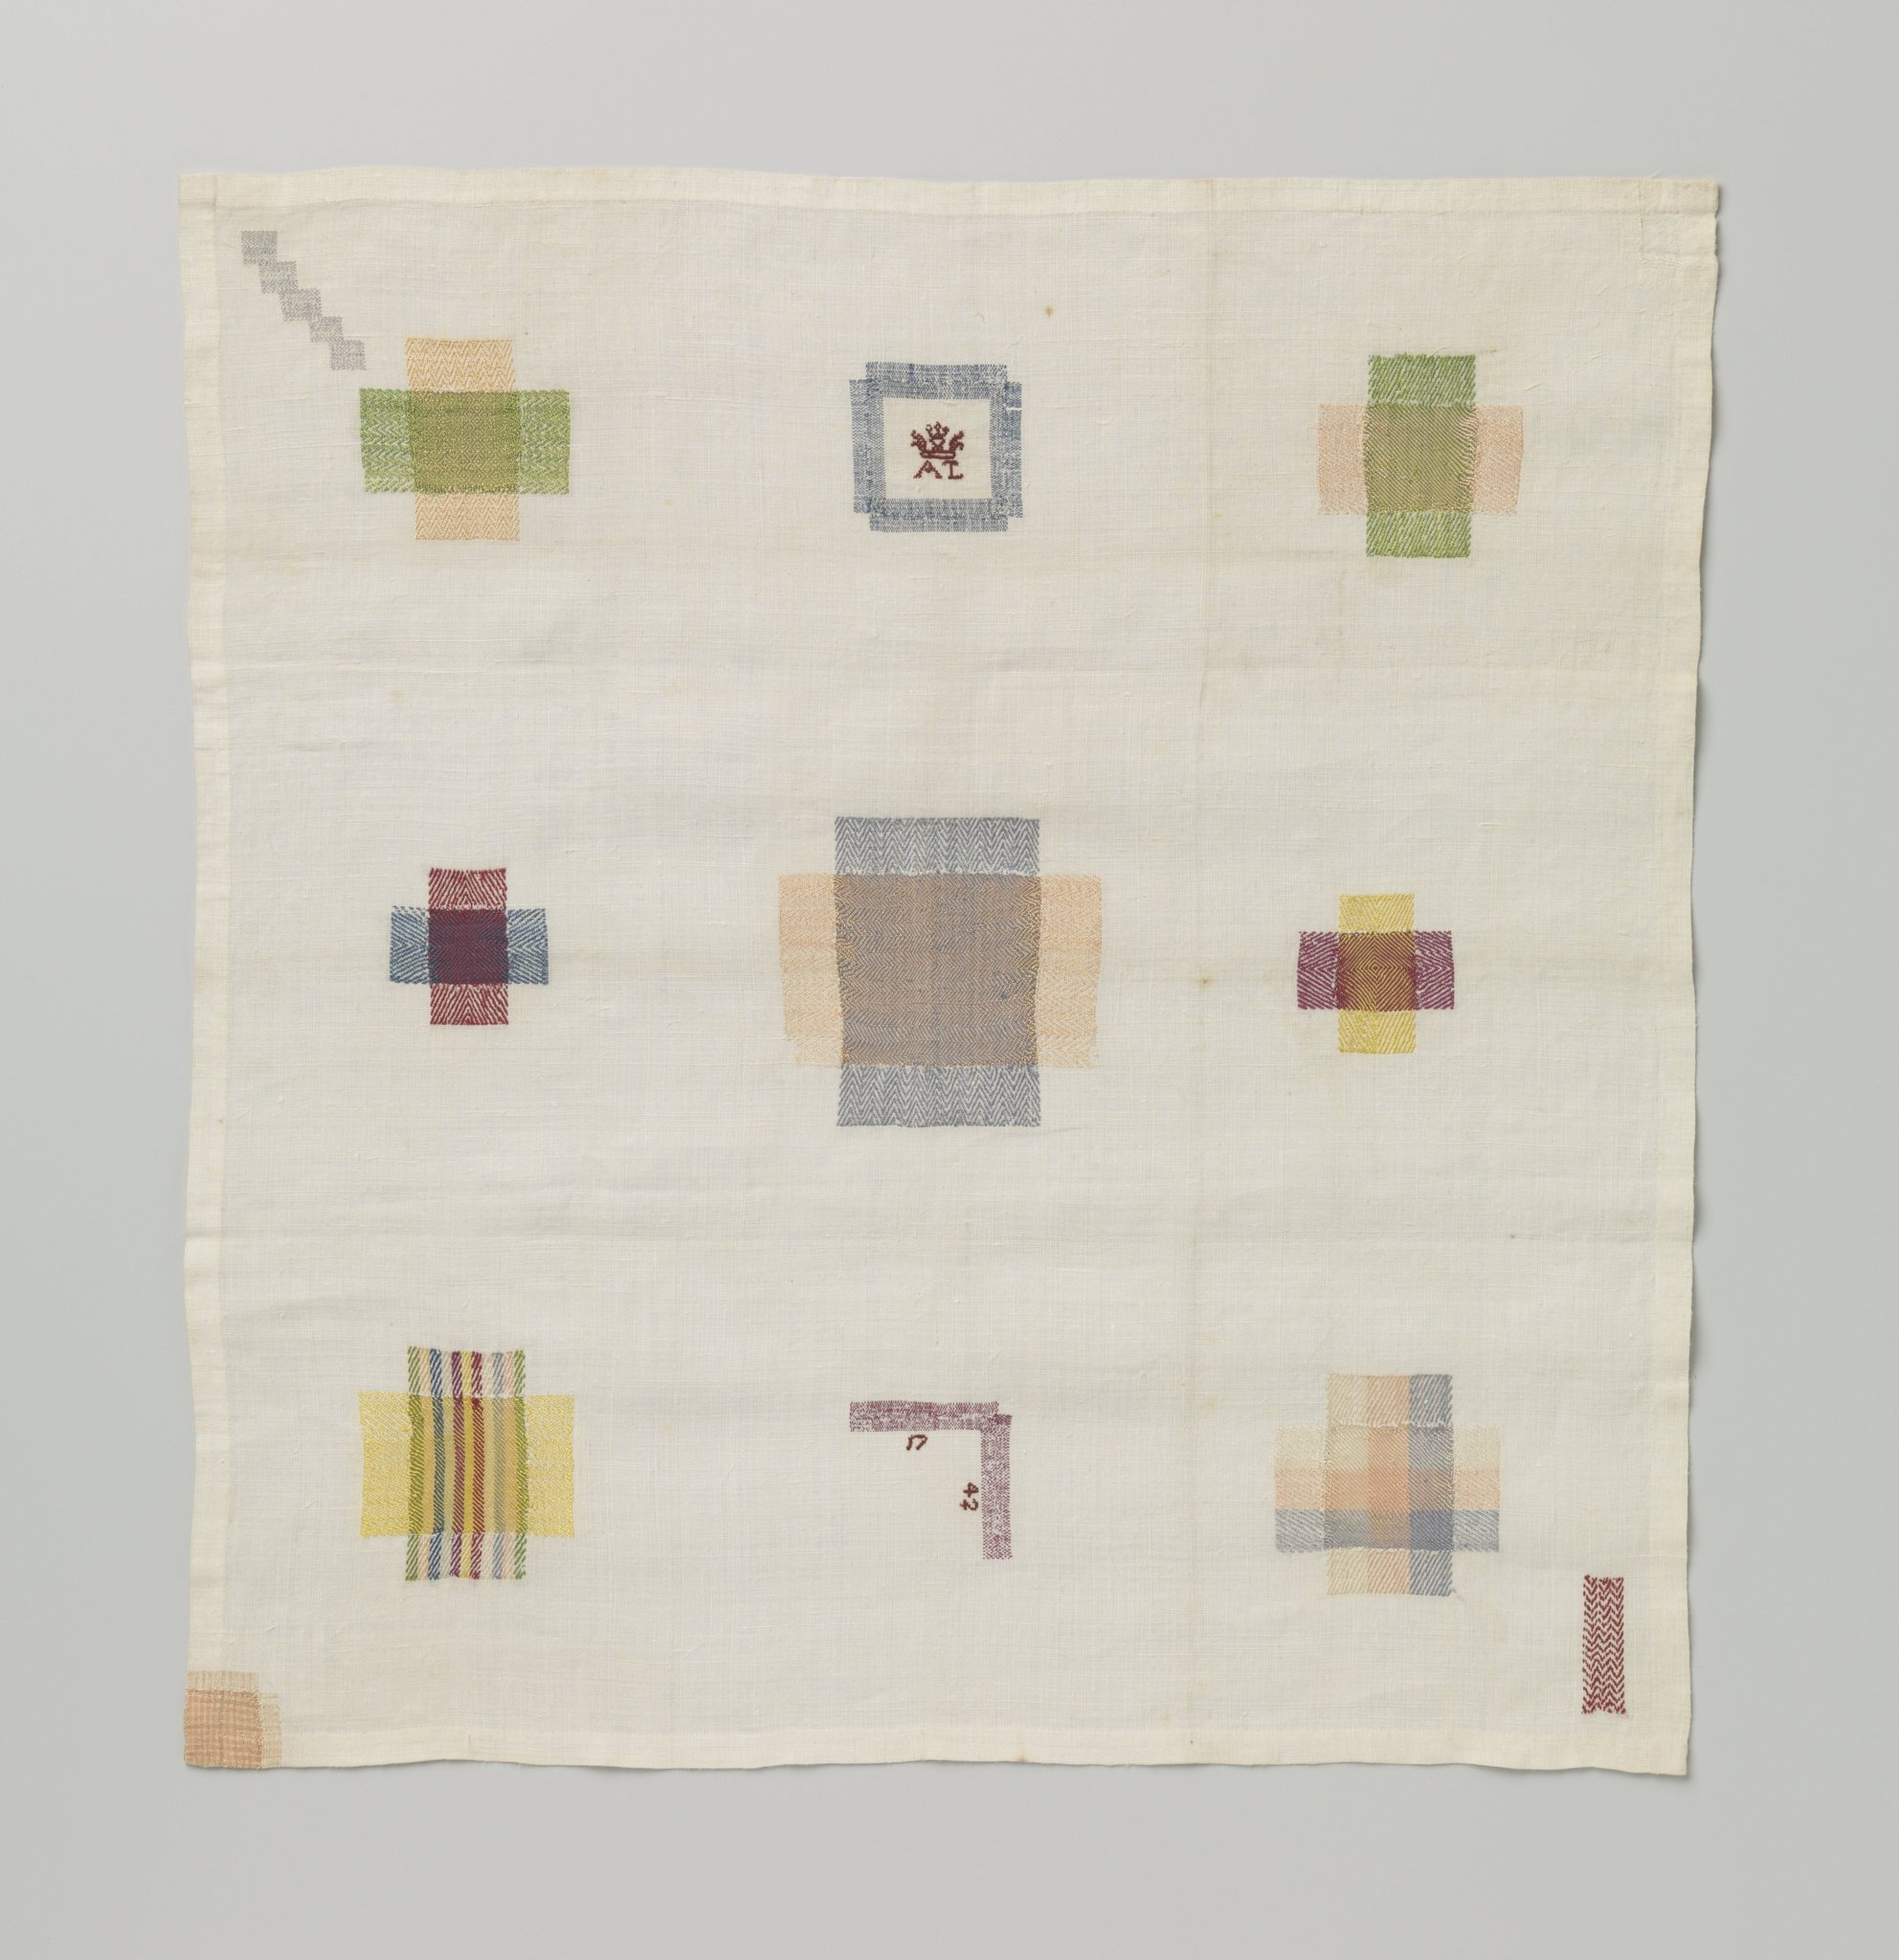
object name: stoplap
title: Stoplap van veelkleurige zijde en linnen op linnen.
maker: Anonymous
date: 1742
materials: linen, silk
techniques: embroidered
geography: netherlands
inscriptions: signature and date: ‘AL, 1742’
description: Stoplap van linnen gestopt met 12 stoppen in veelkleurige zijde. Gedateerd en gesigneerd: 1742, AL. Nederland, 1742.